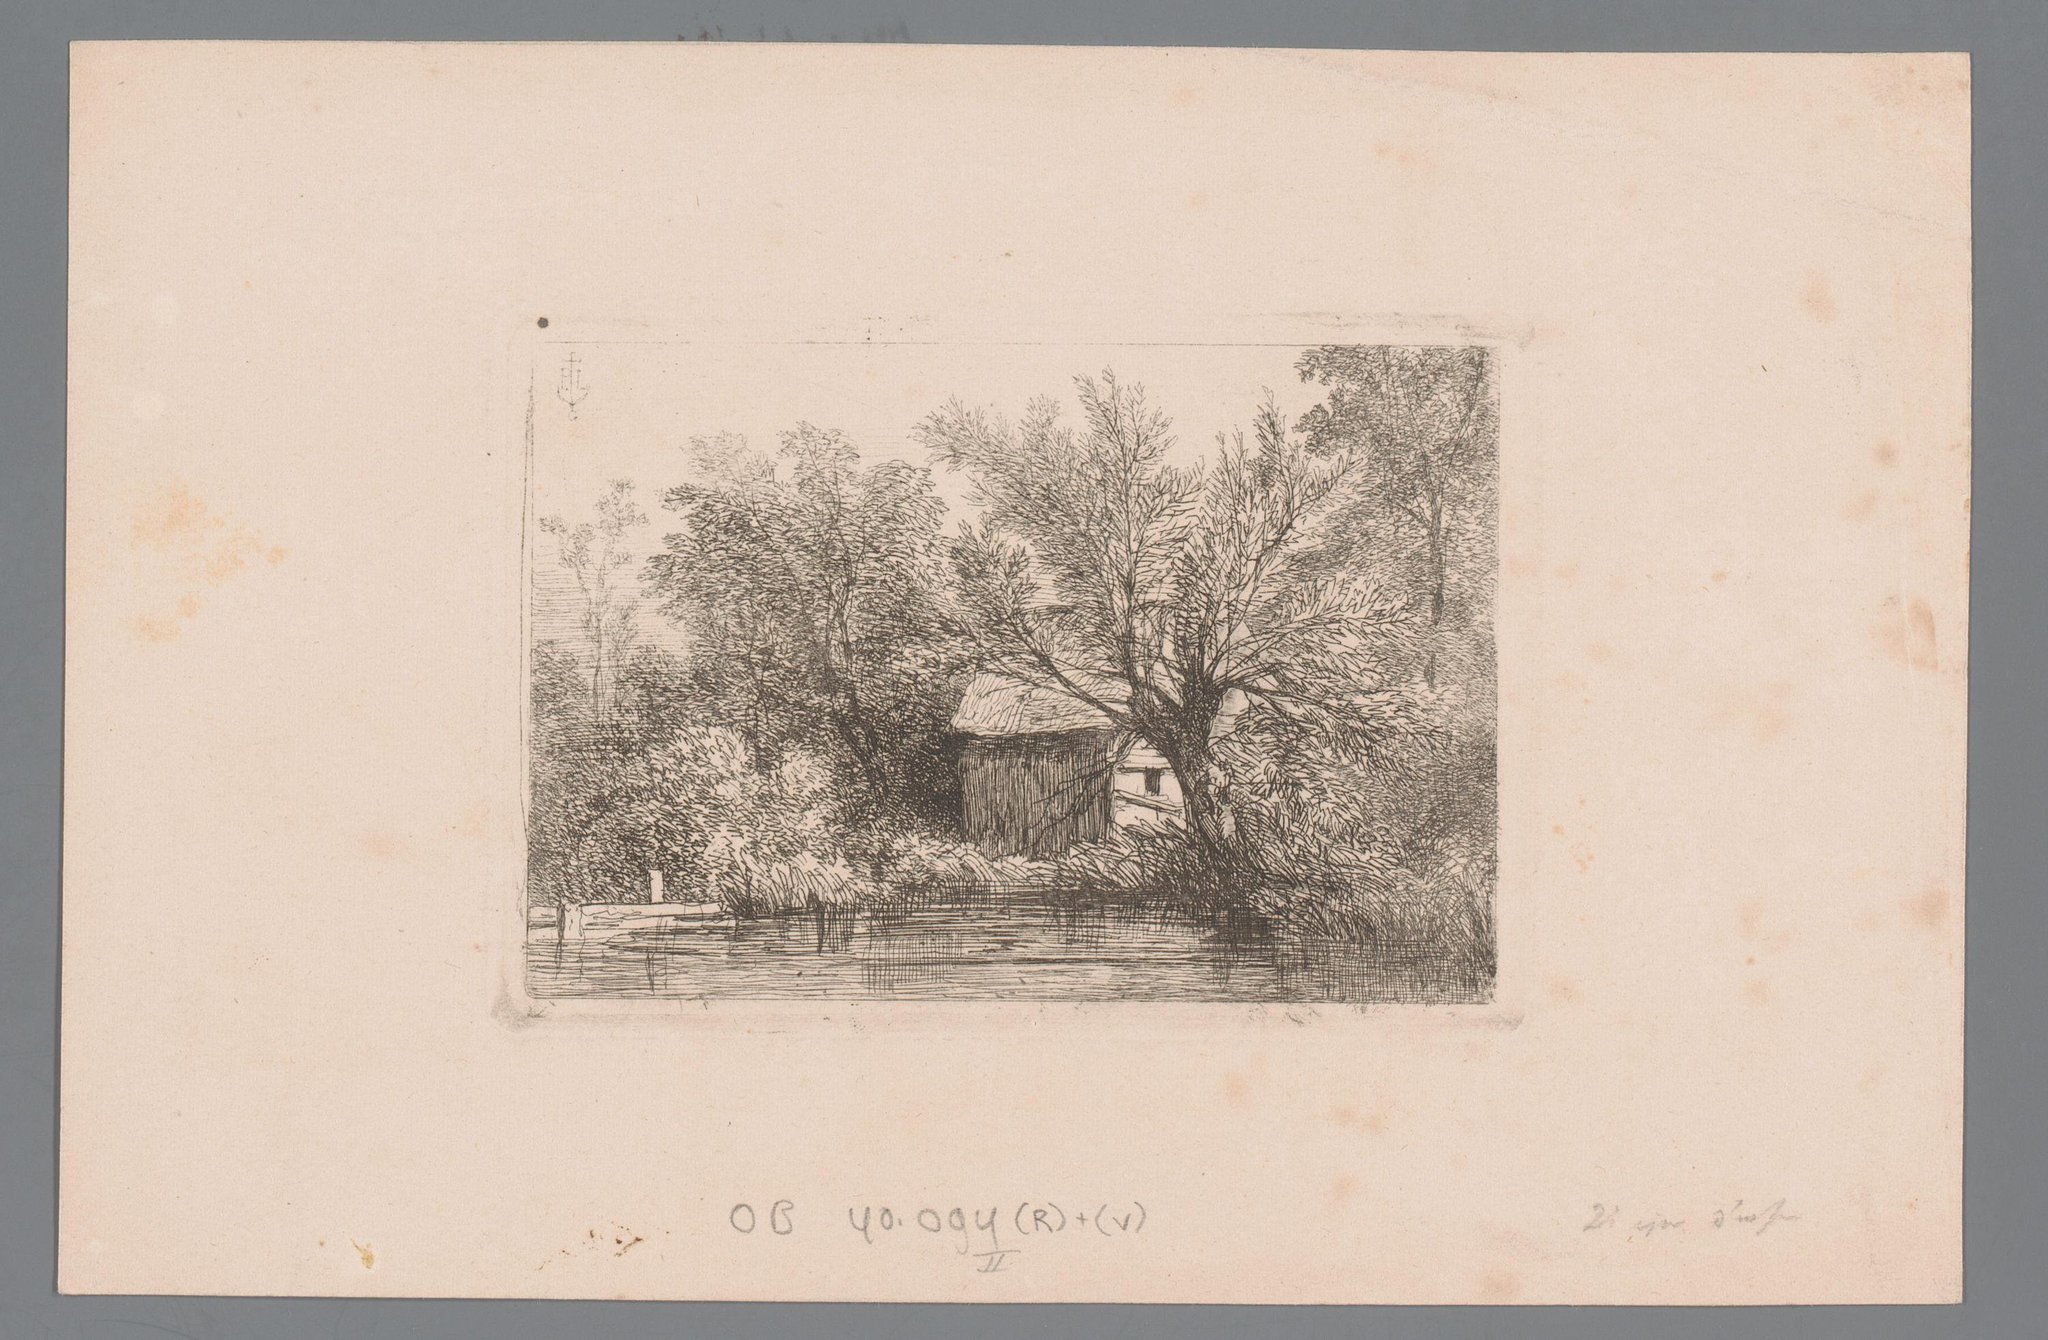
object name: print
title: Klein gebouw tussen bomen aan het water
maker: paulus lauters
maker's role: print maker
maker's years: 1806-1875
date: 1816-1875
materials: paper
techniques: etching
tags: farm or solitary house in landscape